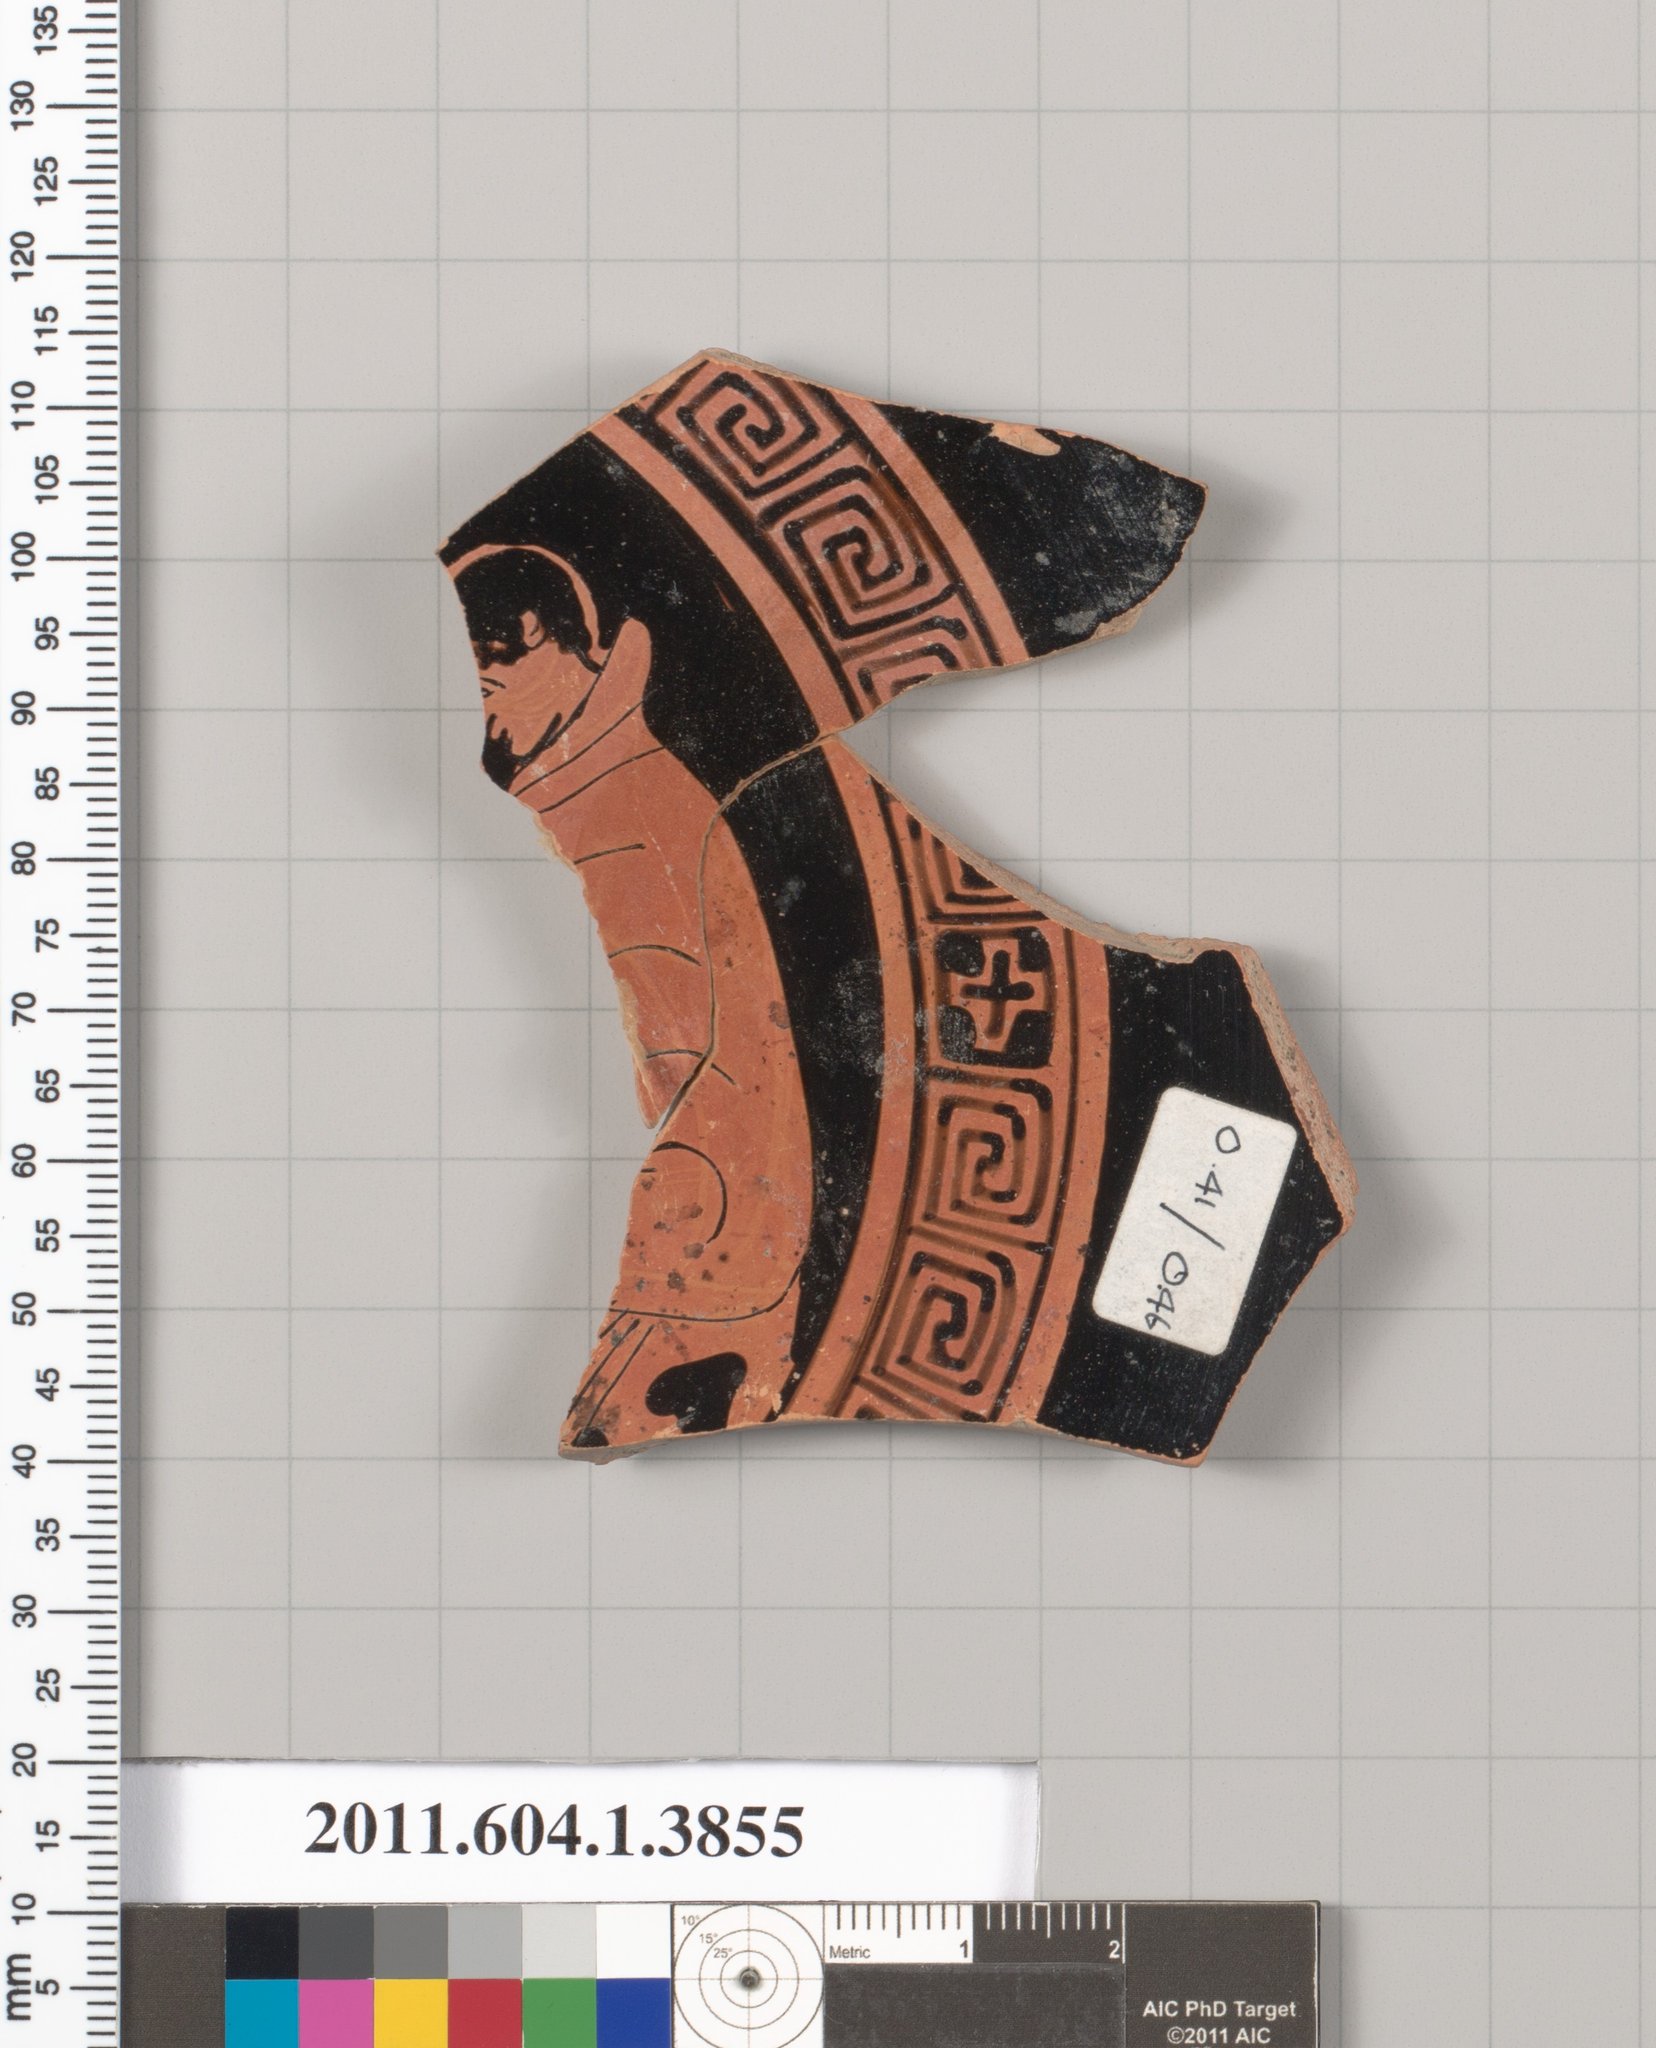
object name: kylix fragment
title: Terracotta fragment of a kylix (drinking cup)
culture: greek, attic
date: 475-451 BCE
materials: terracotta